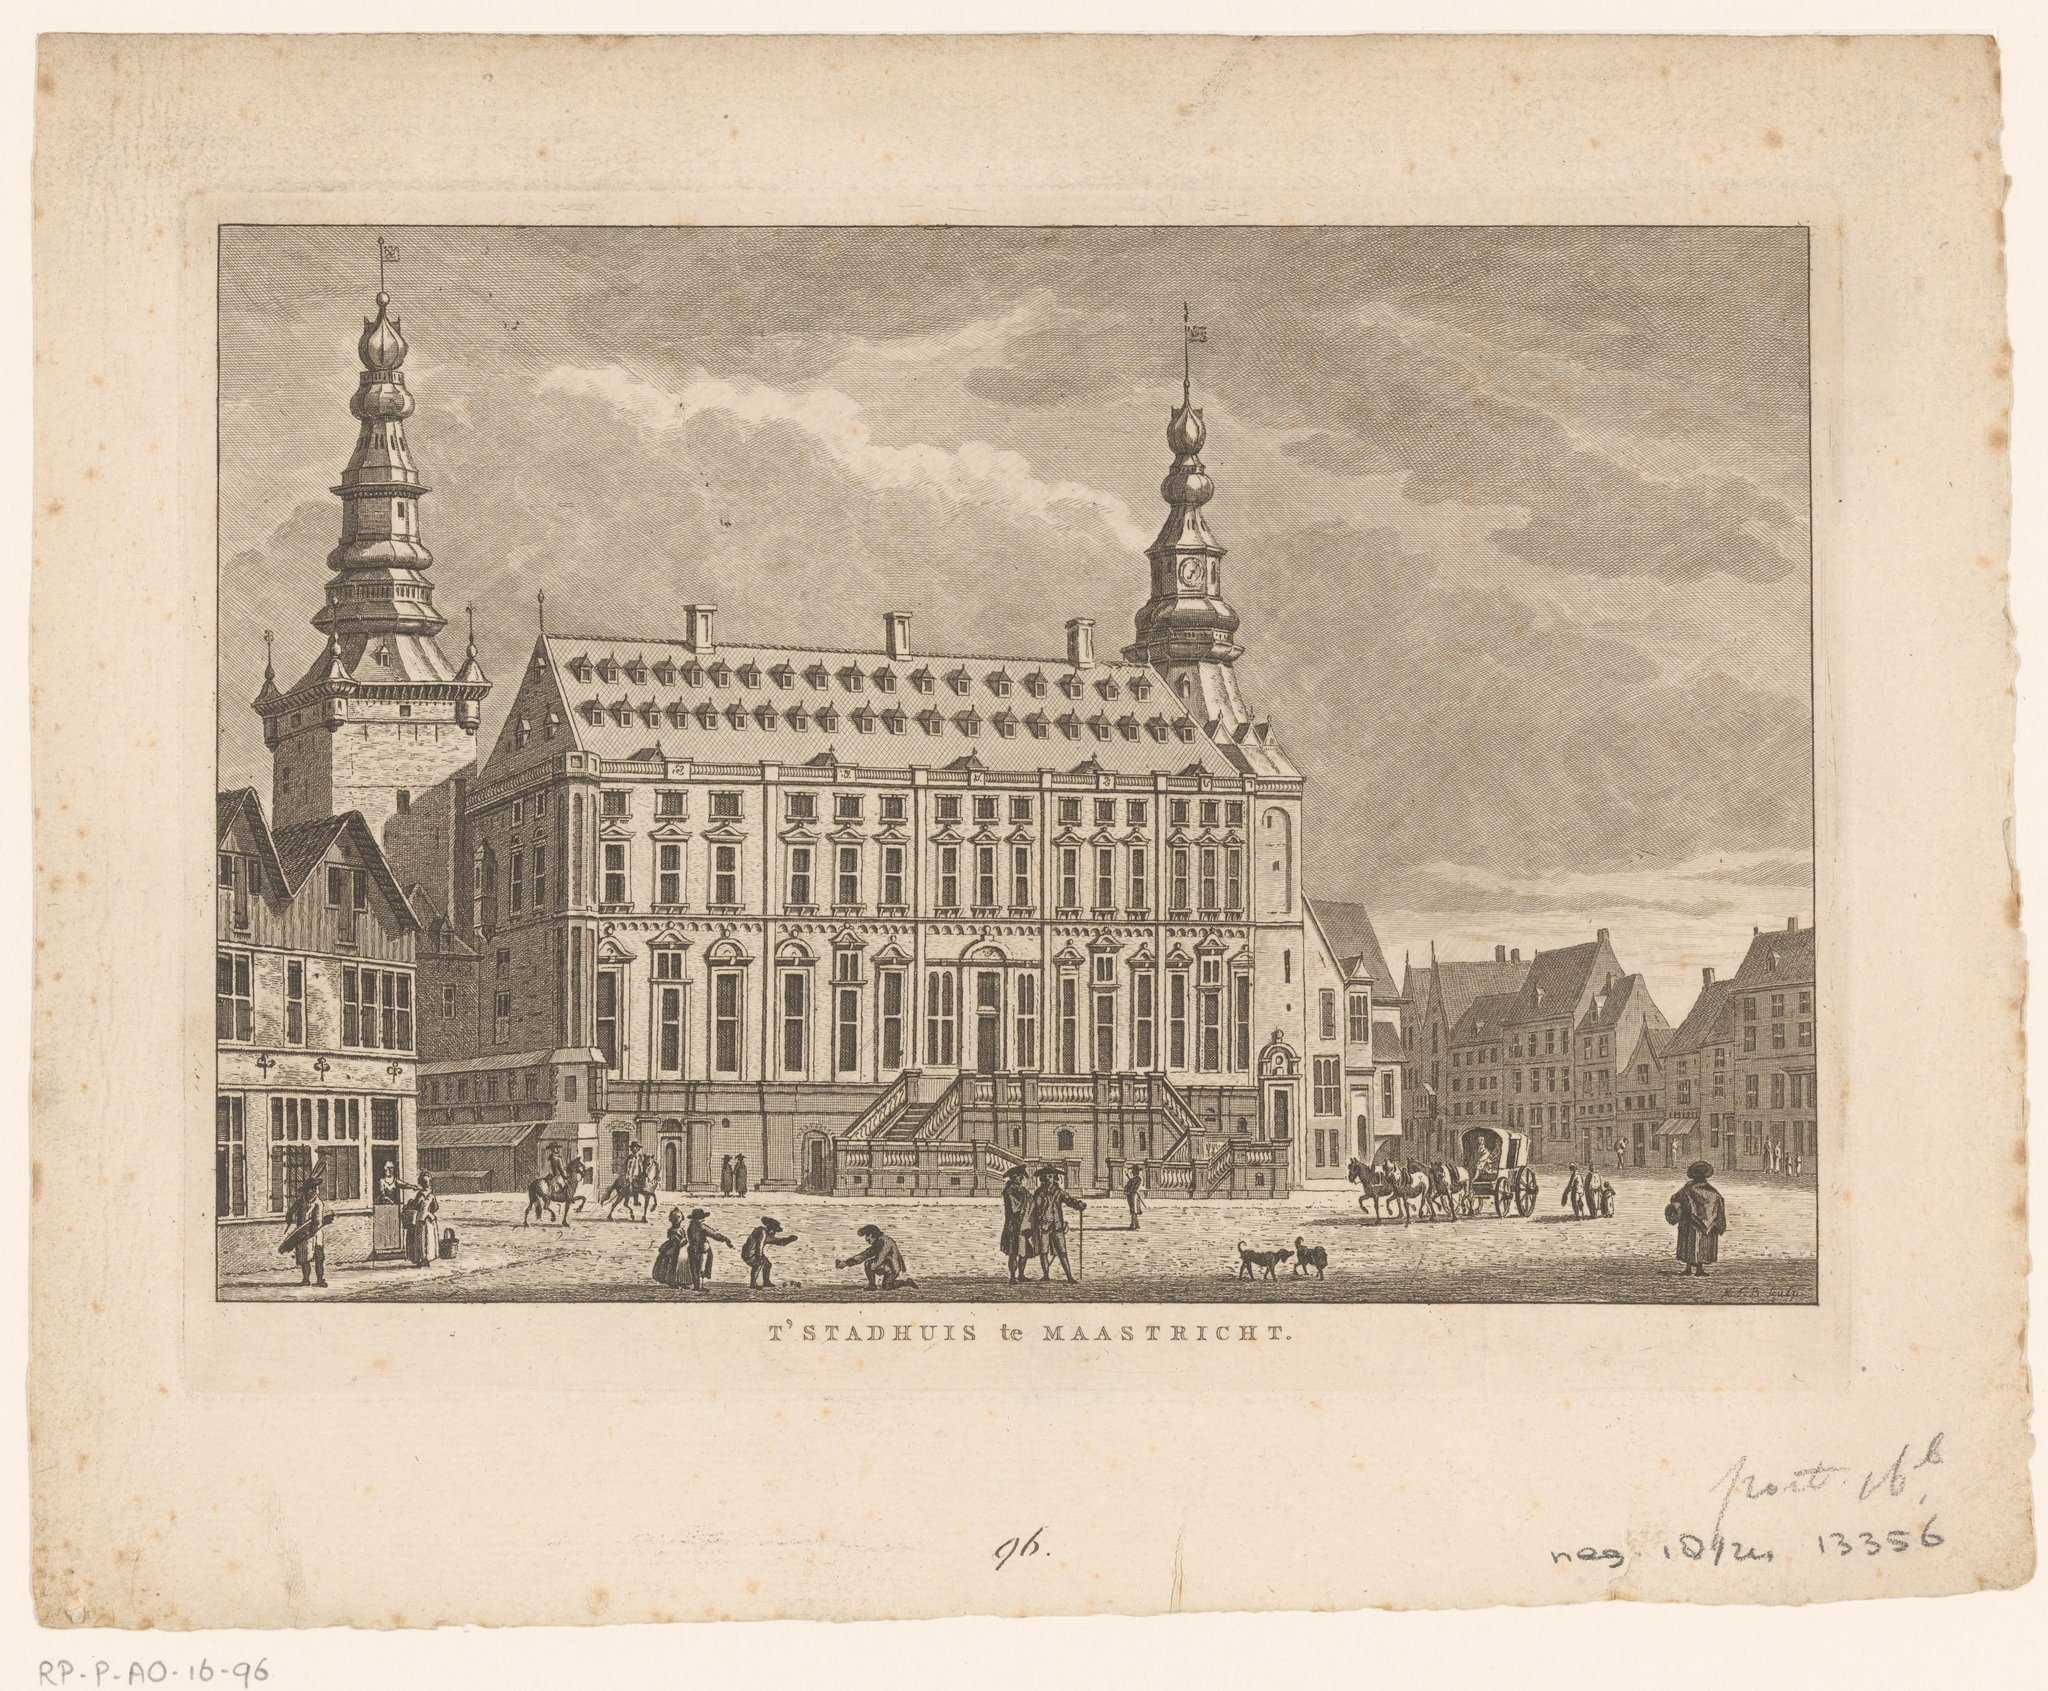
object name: print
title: T' Stadhuis te Maastricht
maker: carel frederik bendorp (i)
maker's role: print maker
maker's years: 1736-1814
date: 1786-1792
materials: paper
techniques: engraving, etching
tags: townhall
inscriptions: collector's mark: Lugt 2228, collector's mark: Lugt 195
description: Prent uit: Vaderlandsche gezichten, of afbeeldingen van den tegenwoordigen staat der Vereenigde Nederlanden (…). Amsterdam: Hendrik Gartman, Willem Vermandel en Jan Willem Smit, 1786-1792. Uitgegeven in afleveringen met ieder een eigen bifolium en inhoudsopgave. Alle prenten in deze publicatie zijn gegraveerd door Carel Frederik Bendorp (I) en, in de meeste gevallen, gebaseerd op tekeningen van Jan Bulthuis.